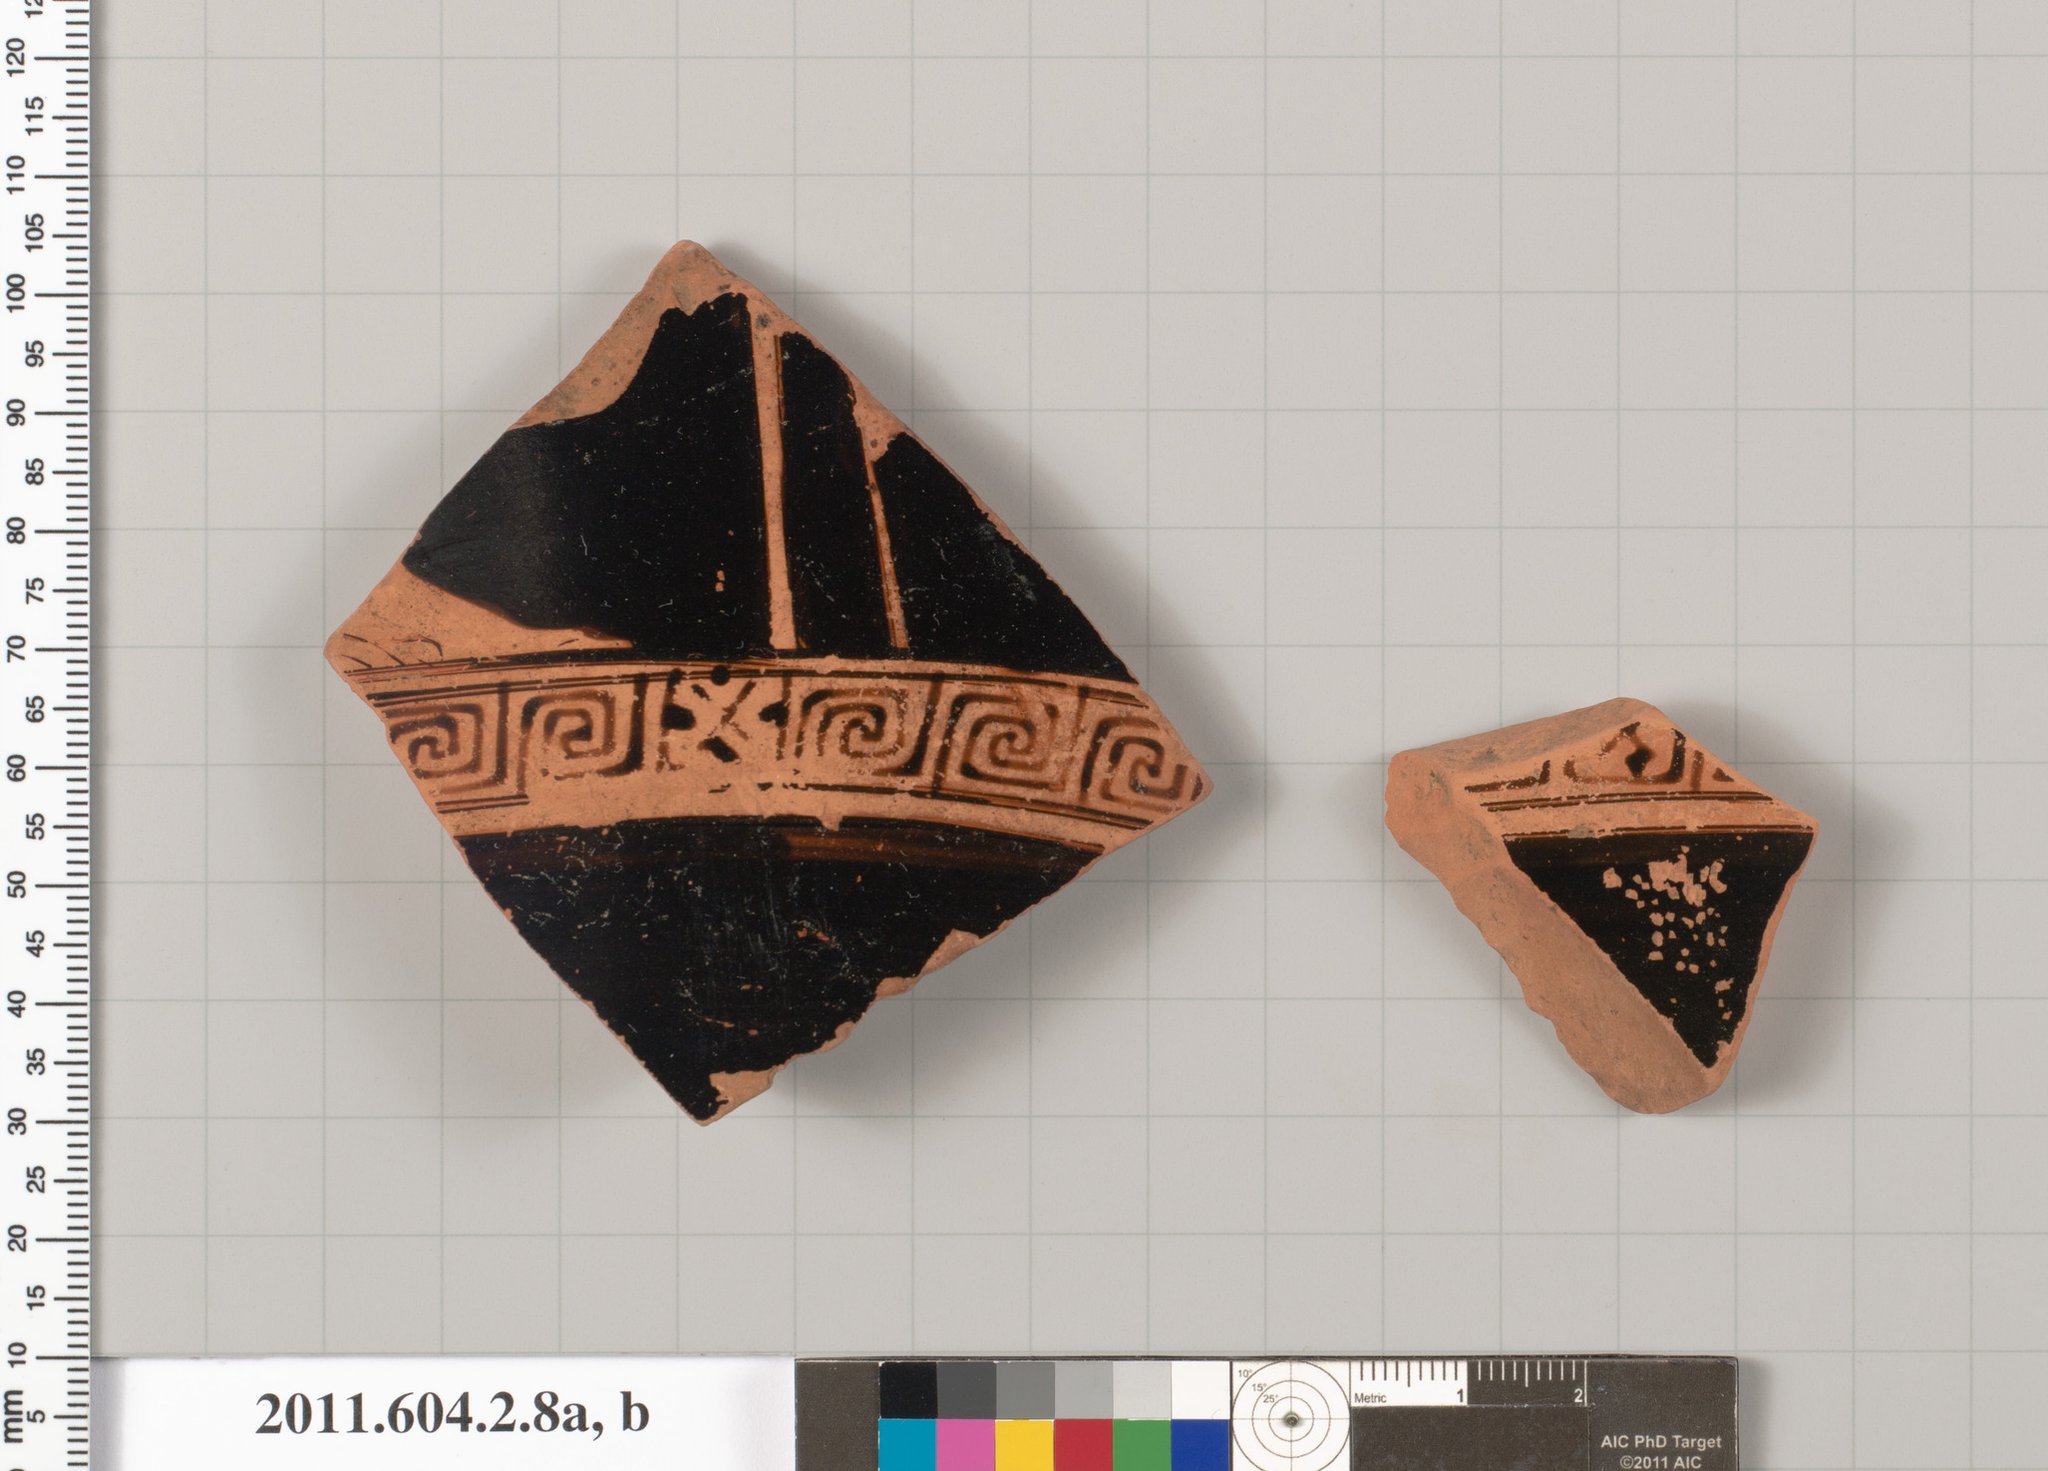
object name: neck amphora fragment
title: Terracotta fragments of a neck-amphora (jar)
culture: greek, attic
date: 460-450 BCE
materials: terracotta